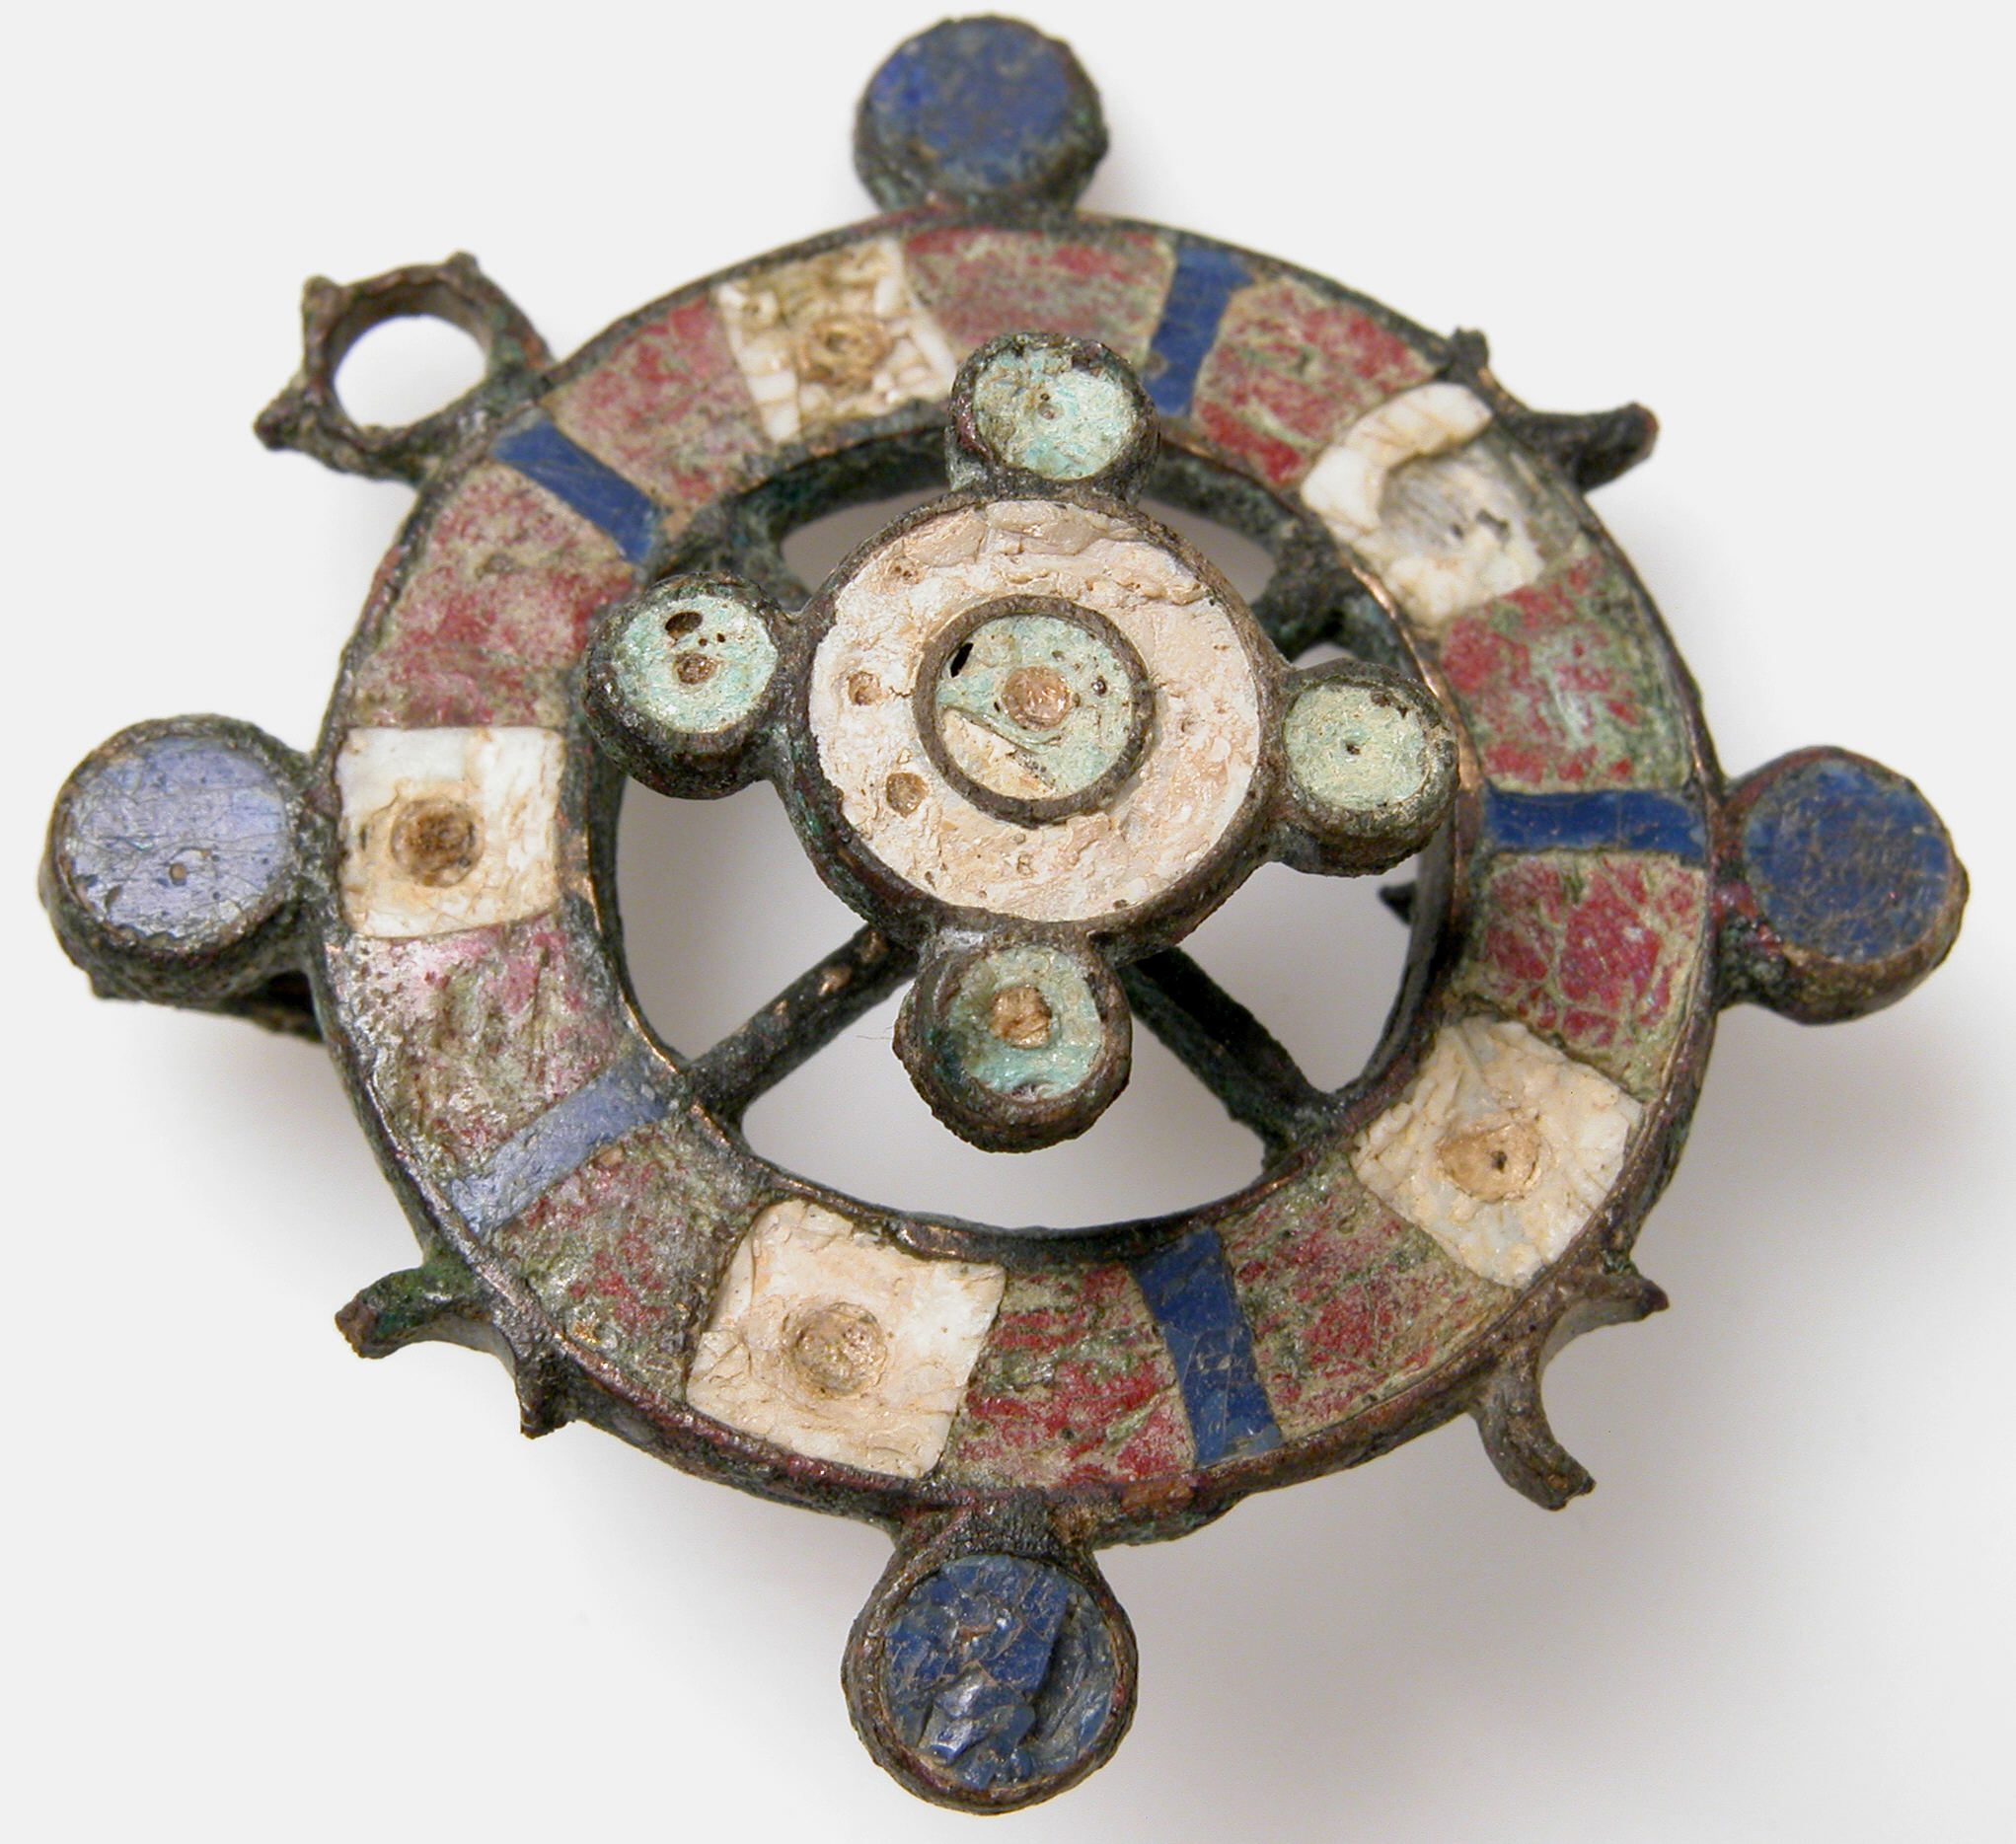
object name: brooch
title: Disk Brooch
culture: roman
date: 100-300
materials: bronze, enamel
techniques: enamel